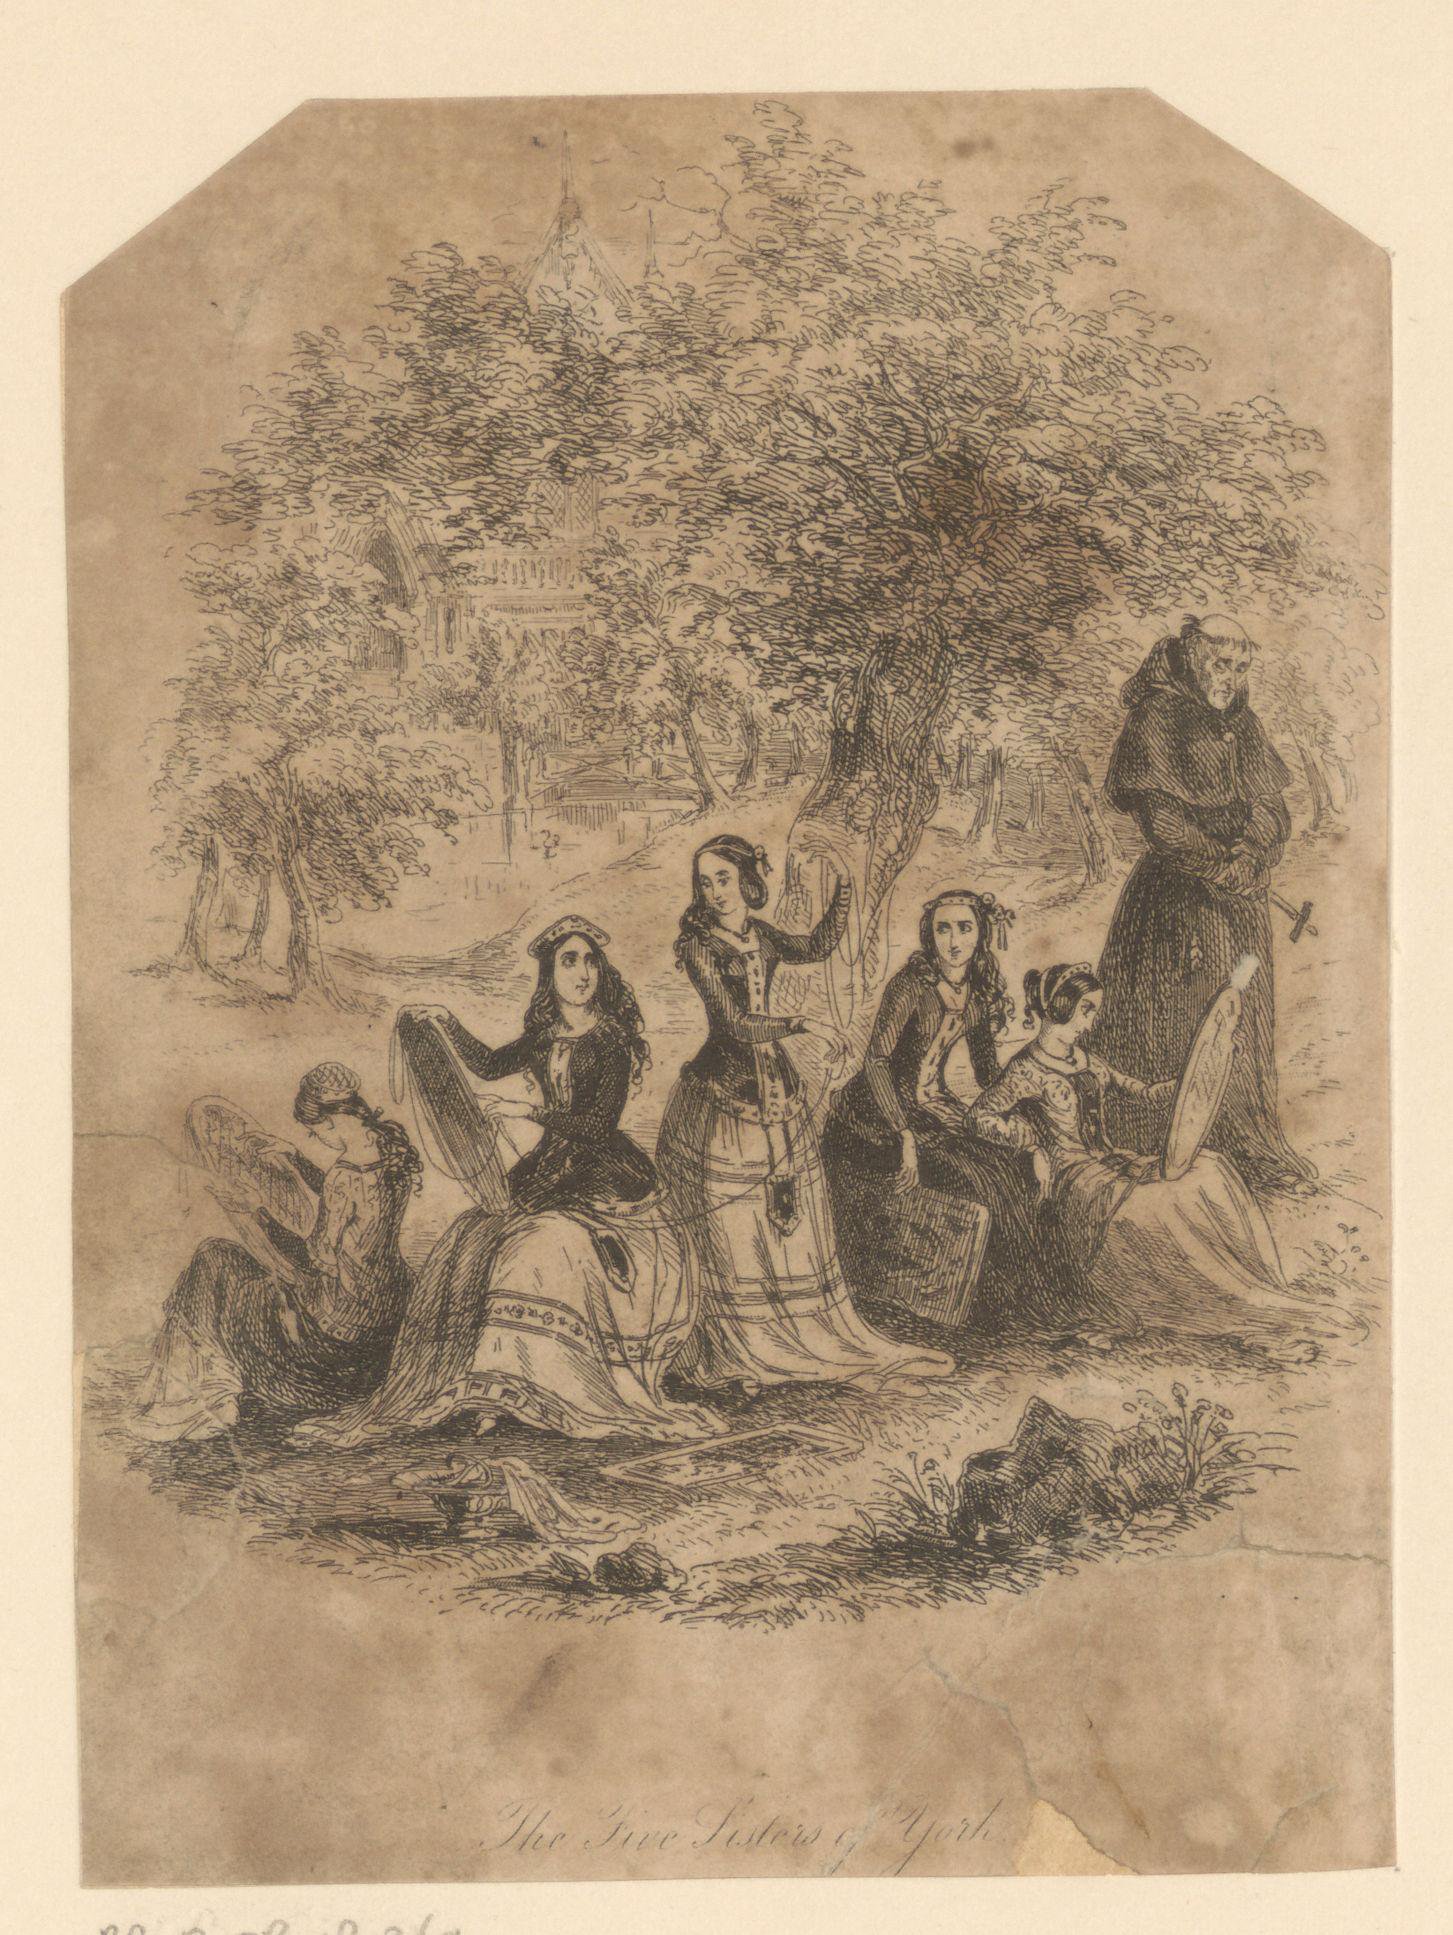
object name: book illustration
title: Vijf vrouwen borduren onder een boom, naast hen staat een monnik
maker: hablot knight browne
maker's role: print maker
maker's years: 1815-1882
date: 1839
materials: paper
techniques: etching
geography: london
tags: monk(s), friar(s), embroidery (ornamentation)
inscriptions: collector's mark: Lugt 2228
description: Prent uit: Dickens, Charles. The life and adventures of Nicholas Nickleby. Londen: Chapman & Hall, 1839.